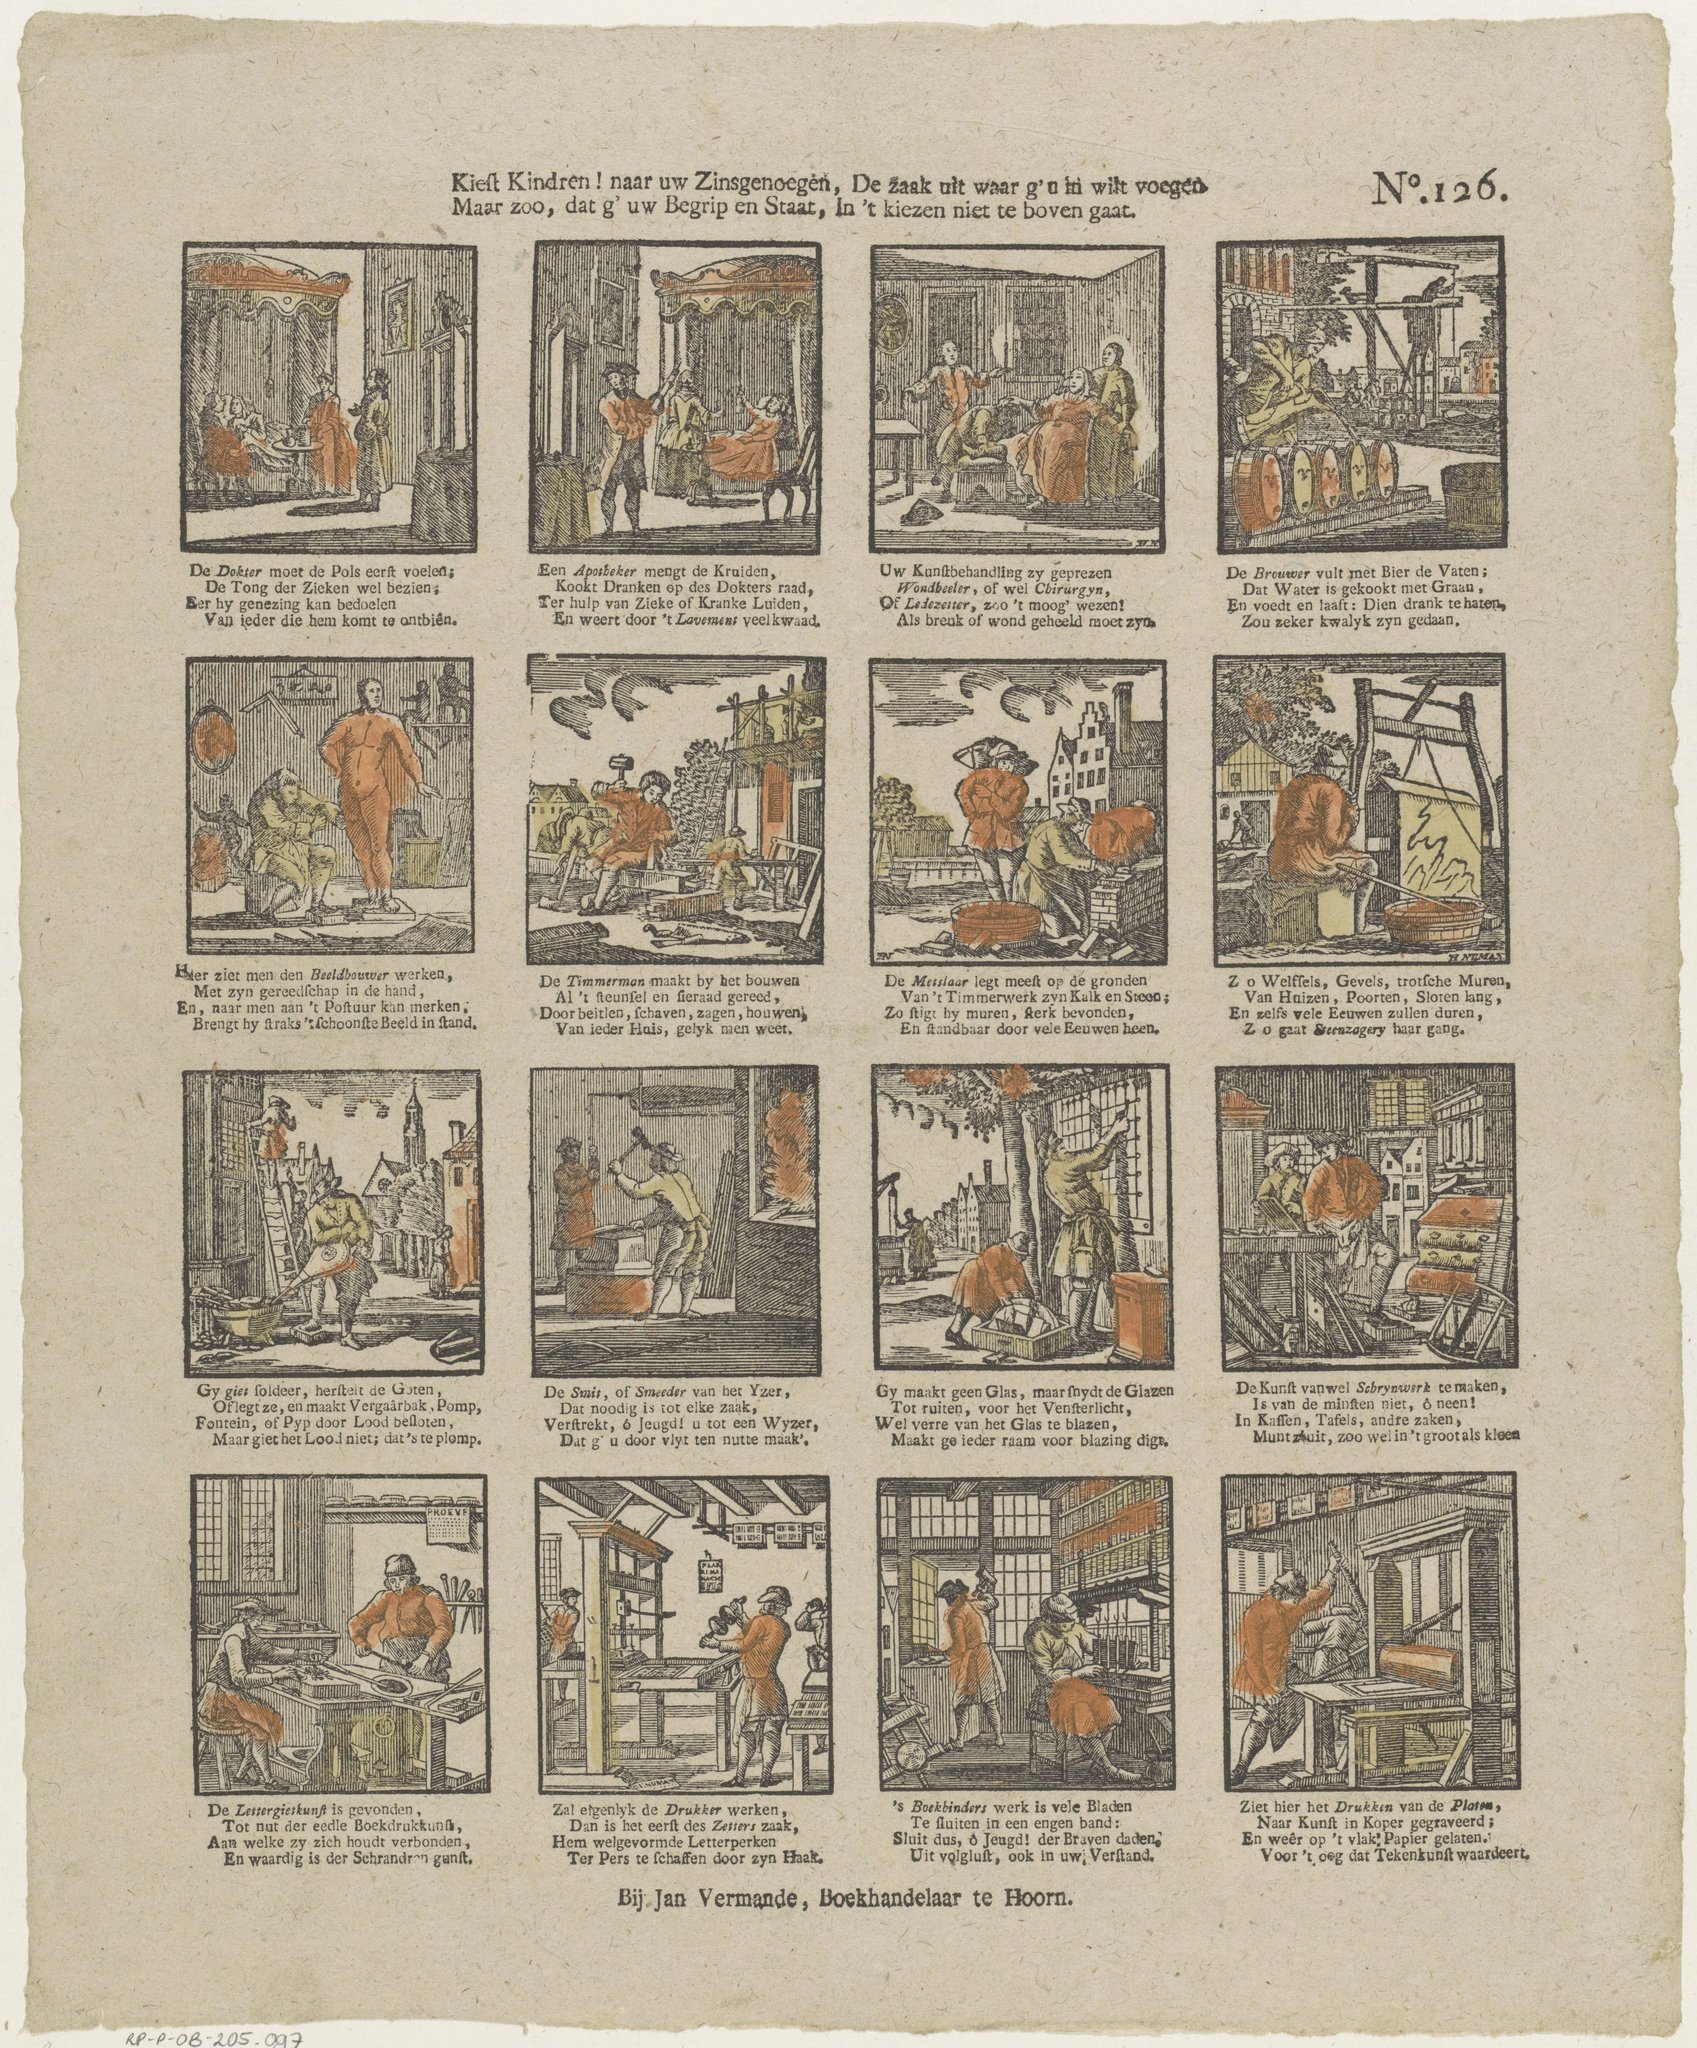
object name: print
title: Kiest kindren! naar uw zinsgenoegen, De zaak uit waar g 'u in wilt voegen / Maar zoo, dat g' uw begrip en staat, In 't kiezen niet te boven gaat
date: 1806-1830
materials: paper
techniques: colour, letterpress printing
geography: zaltbommel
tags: craft-production, skilled handiwork, pharmacist, druggist, apothecary; pharmacy, drugstore, dispensing chemist, sculptor at work, physician, doctor, crafts and industries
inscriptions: collector's mark: Lugt 2760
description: Blad met 16 voorstellingen van ambachtslieden en beroepen, zoals dokter, apotheker en beeldhouwer. Onder elke afbeelding een vierregelig vers. Genummerd rechtsboven: No. 126.